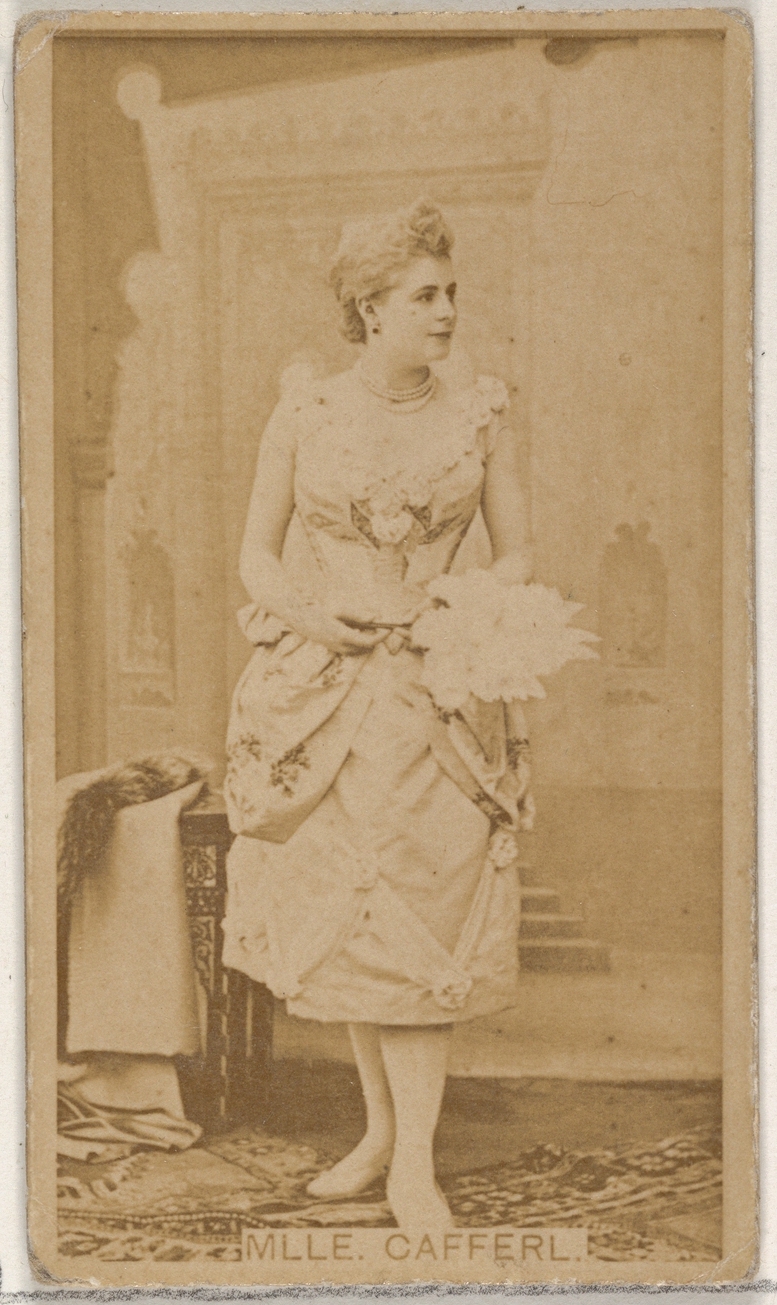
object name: photograph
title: Mlle. Cafferl, from the Actors and Actresses series (N45, Type 8) for Virginia Brights Cigarettes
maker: allen & ginter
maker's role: publisher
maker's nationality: american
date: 1888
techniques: albumen silver print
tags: portraits,women,actresses